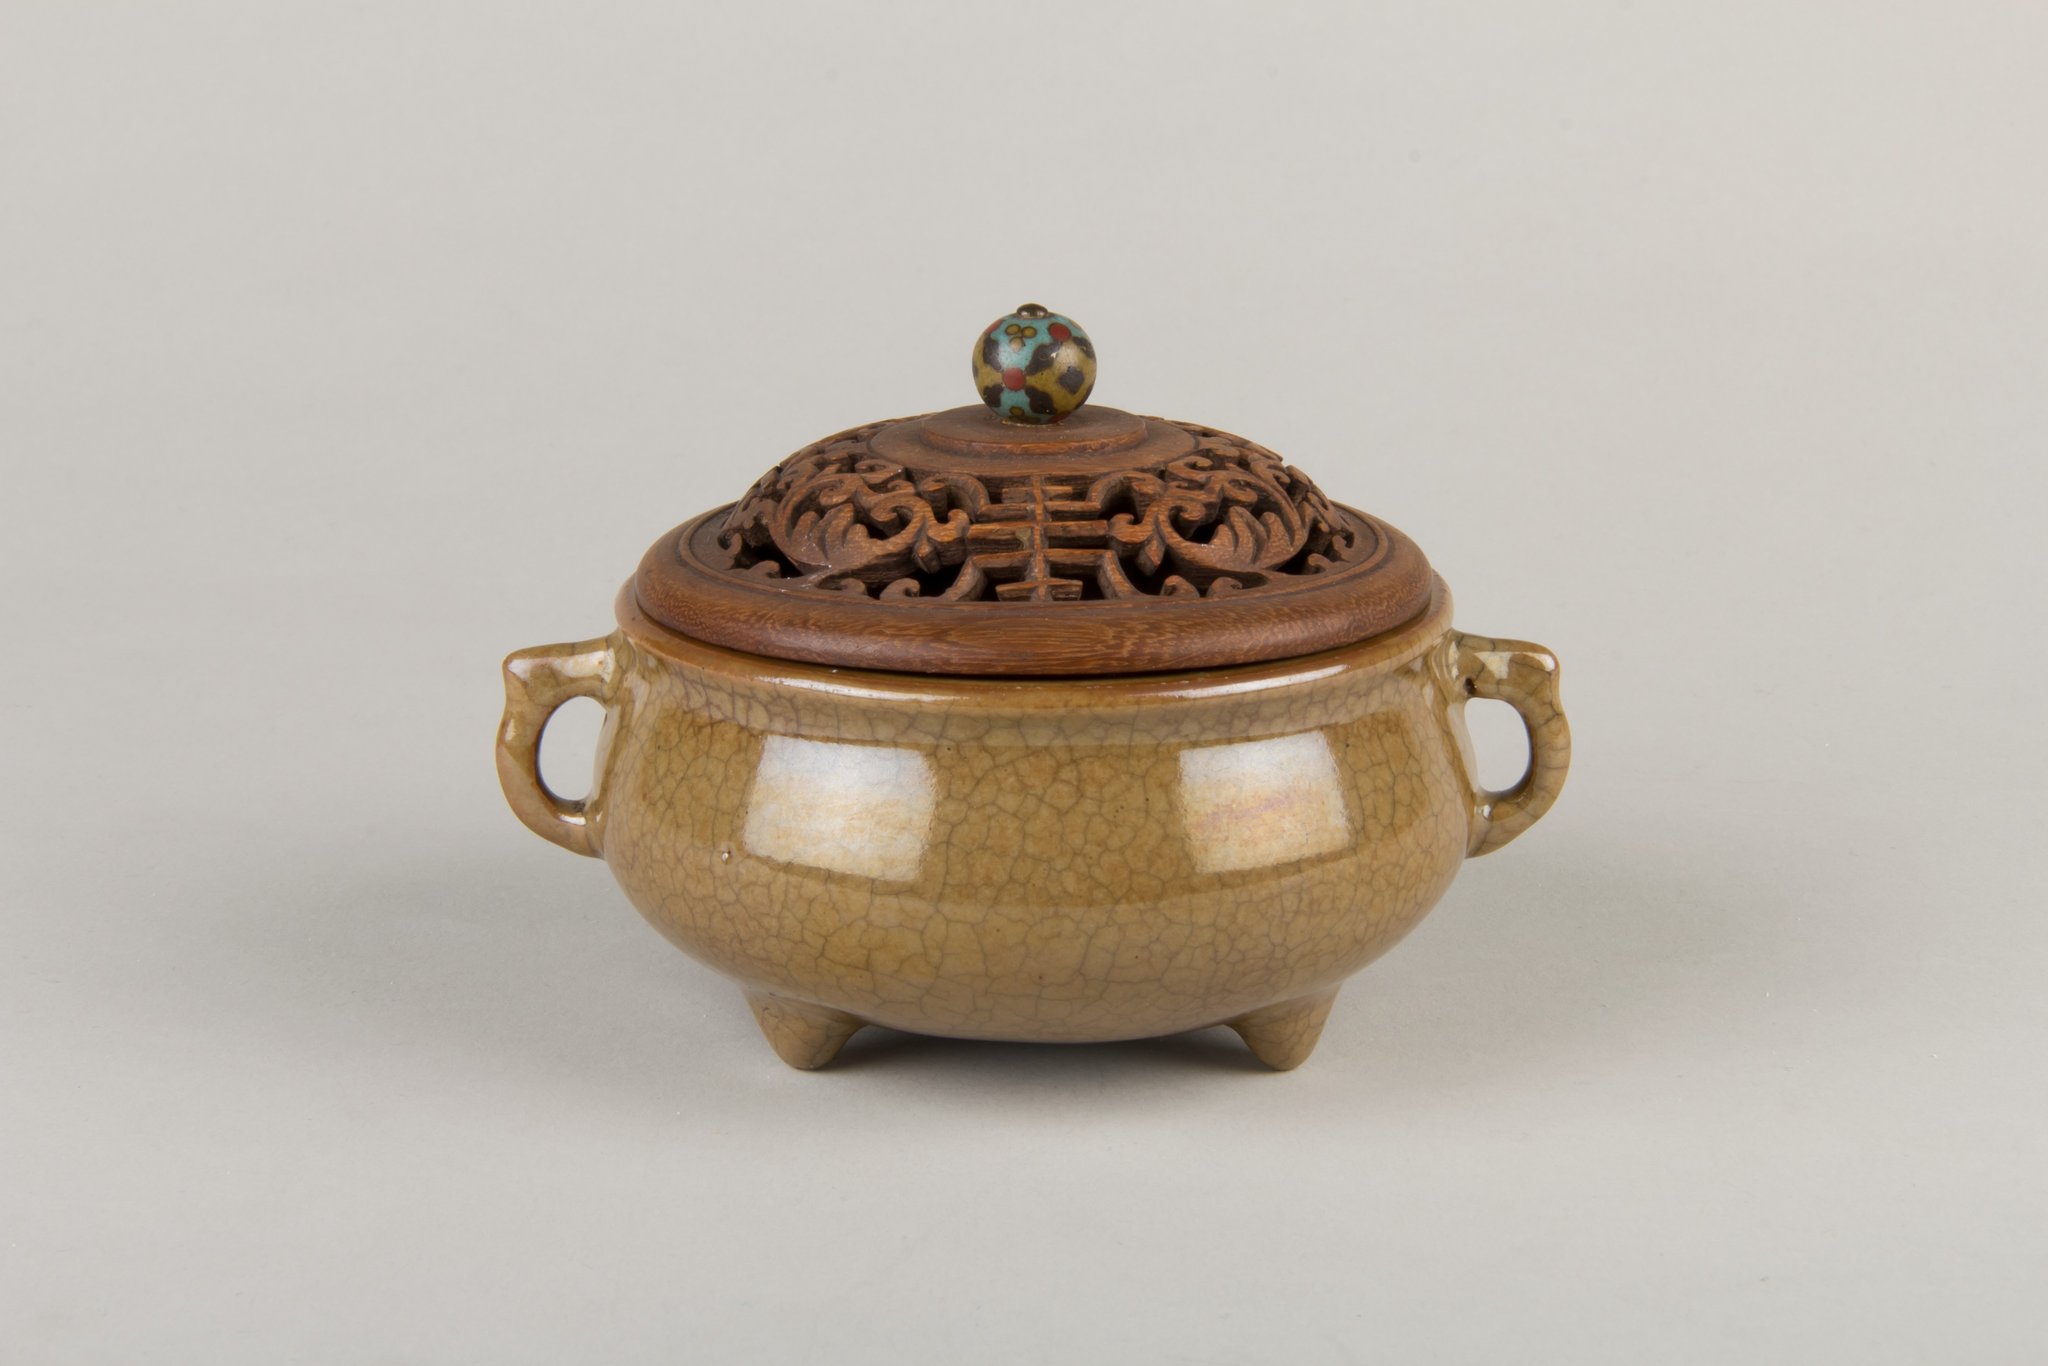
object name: incense burner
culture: chinese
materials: glaze, porcelain